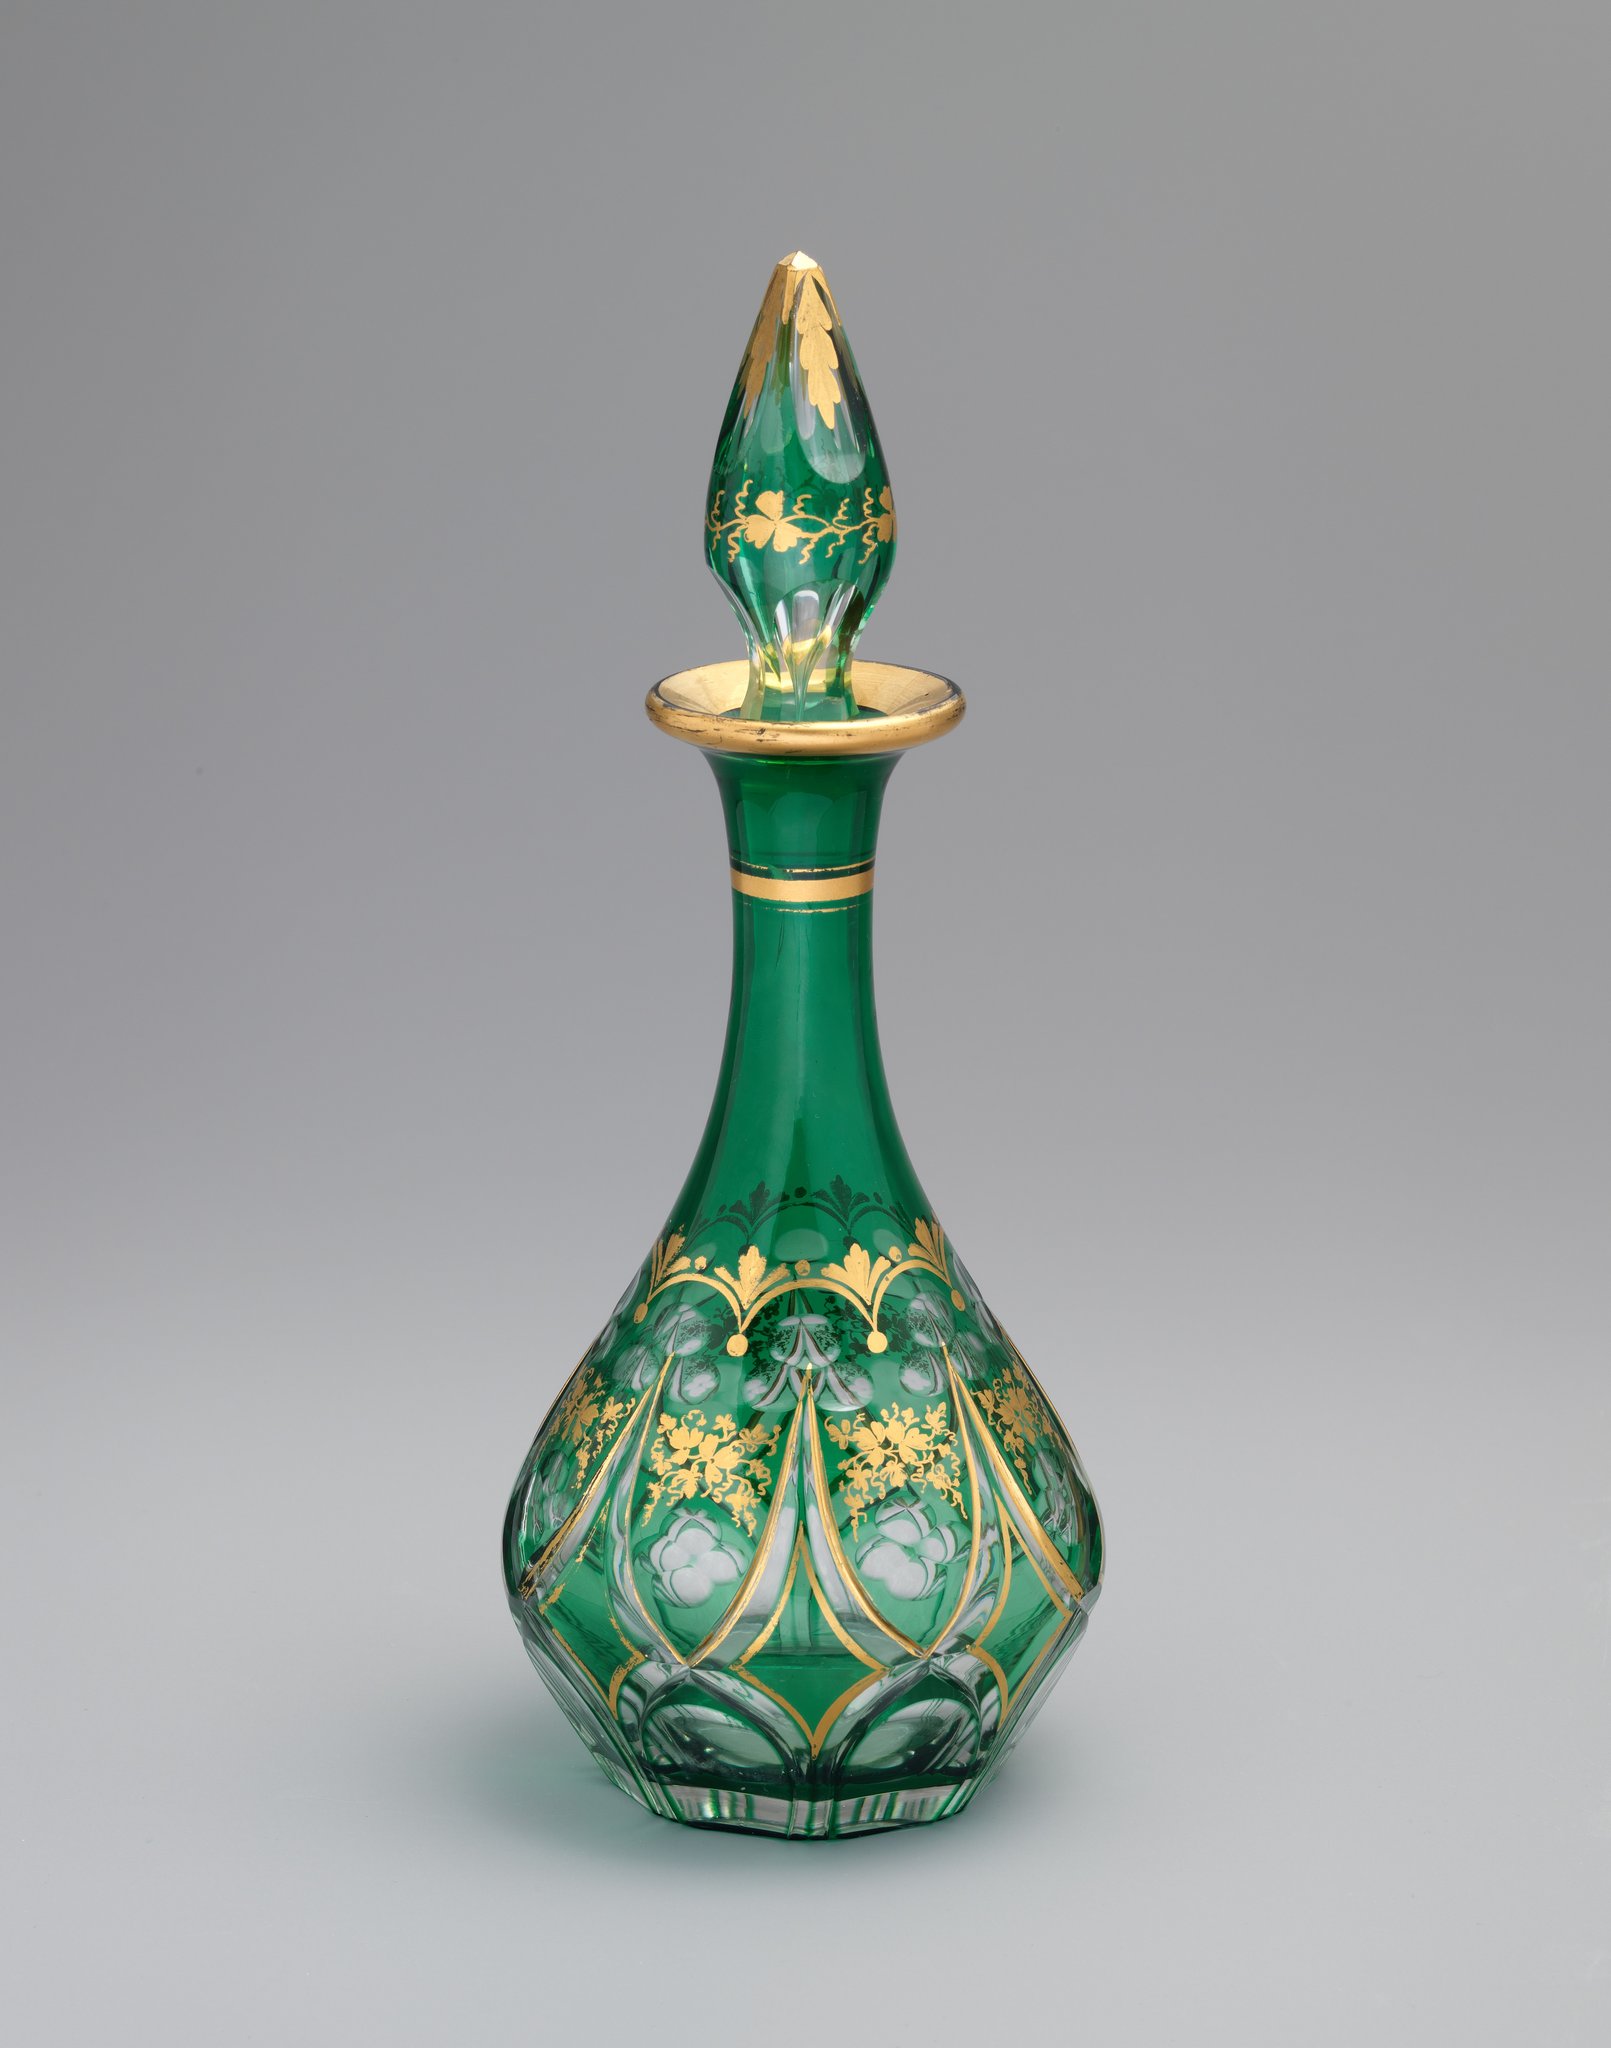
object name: decanter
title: Perfume decanter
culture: american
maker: new england glass company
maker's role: manufacturer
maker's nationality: american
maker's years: 1818-1888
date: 1866-1870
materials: glass, lead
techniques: glassblowing, cutting, gilding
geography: united states